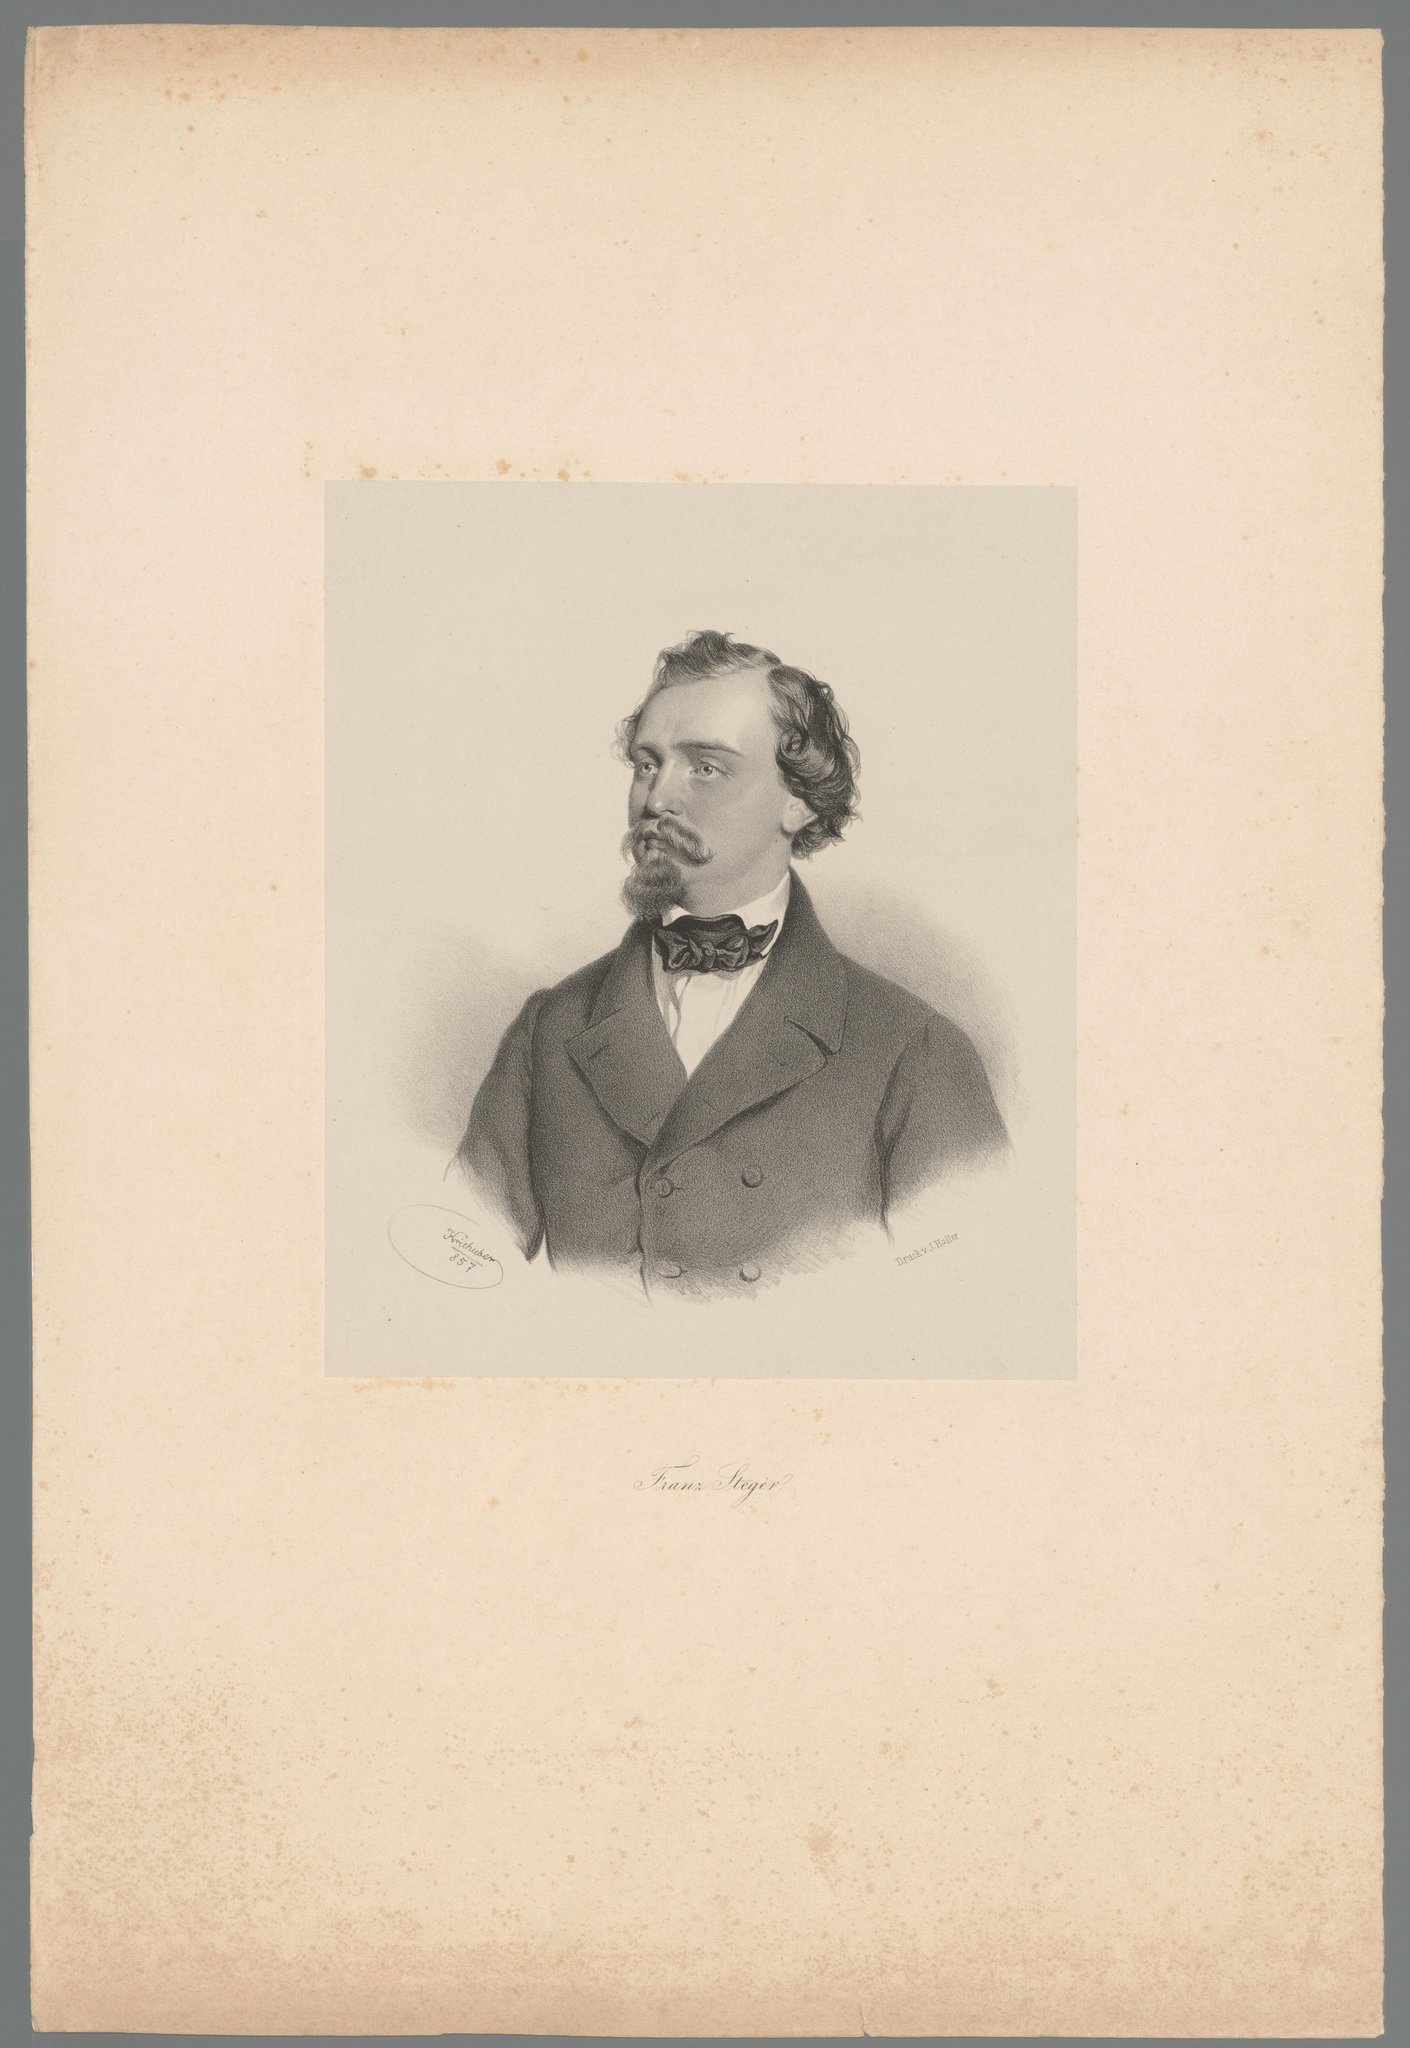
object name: print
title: Franz Steger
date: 1857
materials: paper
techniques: lithograph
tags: historical persons, portrait of opera-singer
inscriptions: collector's mark: Lugt 2228